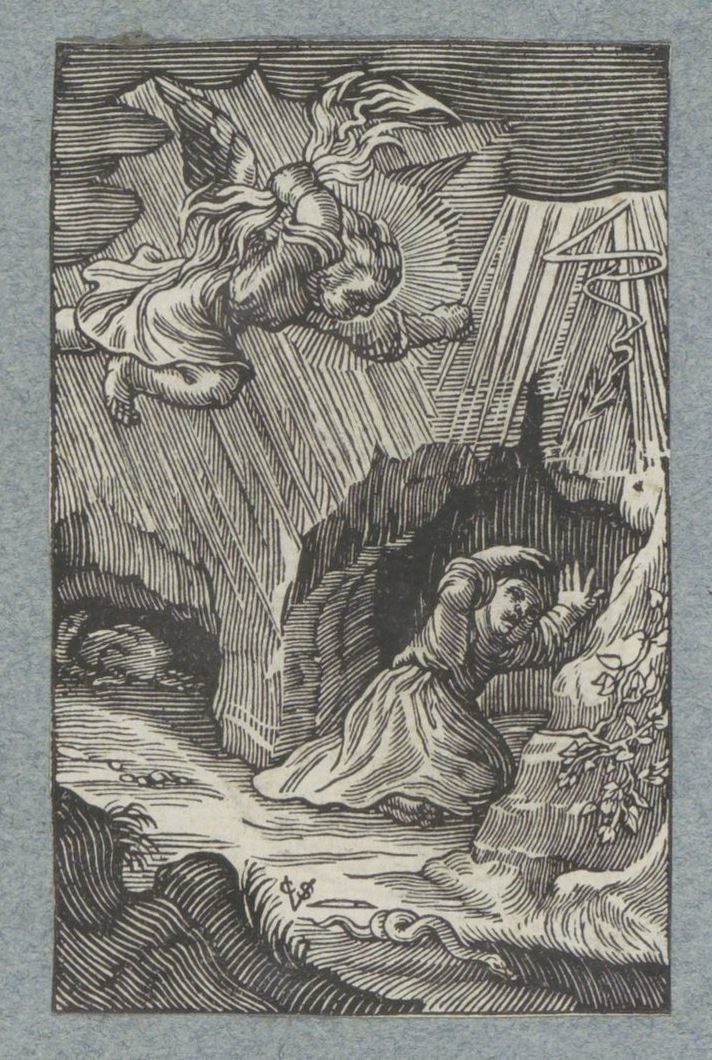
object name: print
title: Kind schuilt voor onweer in een grot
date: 1628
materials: paper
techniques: woodcut, pasting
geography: amsterdam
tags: thunderstorm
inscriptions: collector's mark: Lugt 2165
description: Prent uit: Herman Hugo, Pia desideria emblematis, elegiis & affectibus S. S. Patrum illustrata, Antwerpen 1628. Volgens de titelpagina verscheen dit werk in Antwerpen bij Hendrick Aertssens, in werkelijkheid verscheen het in Amsterdam bij Pieter Jacobsz Paets (Dietz 2012, p. 58-59).